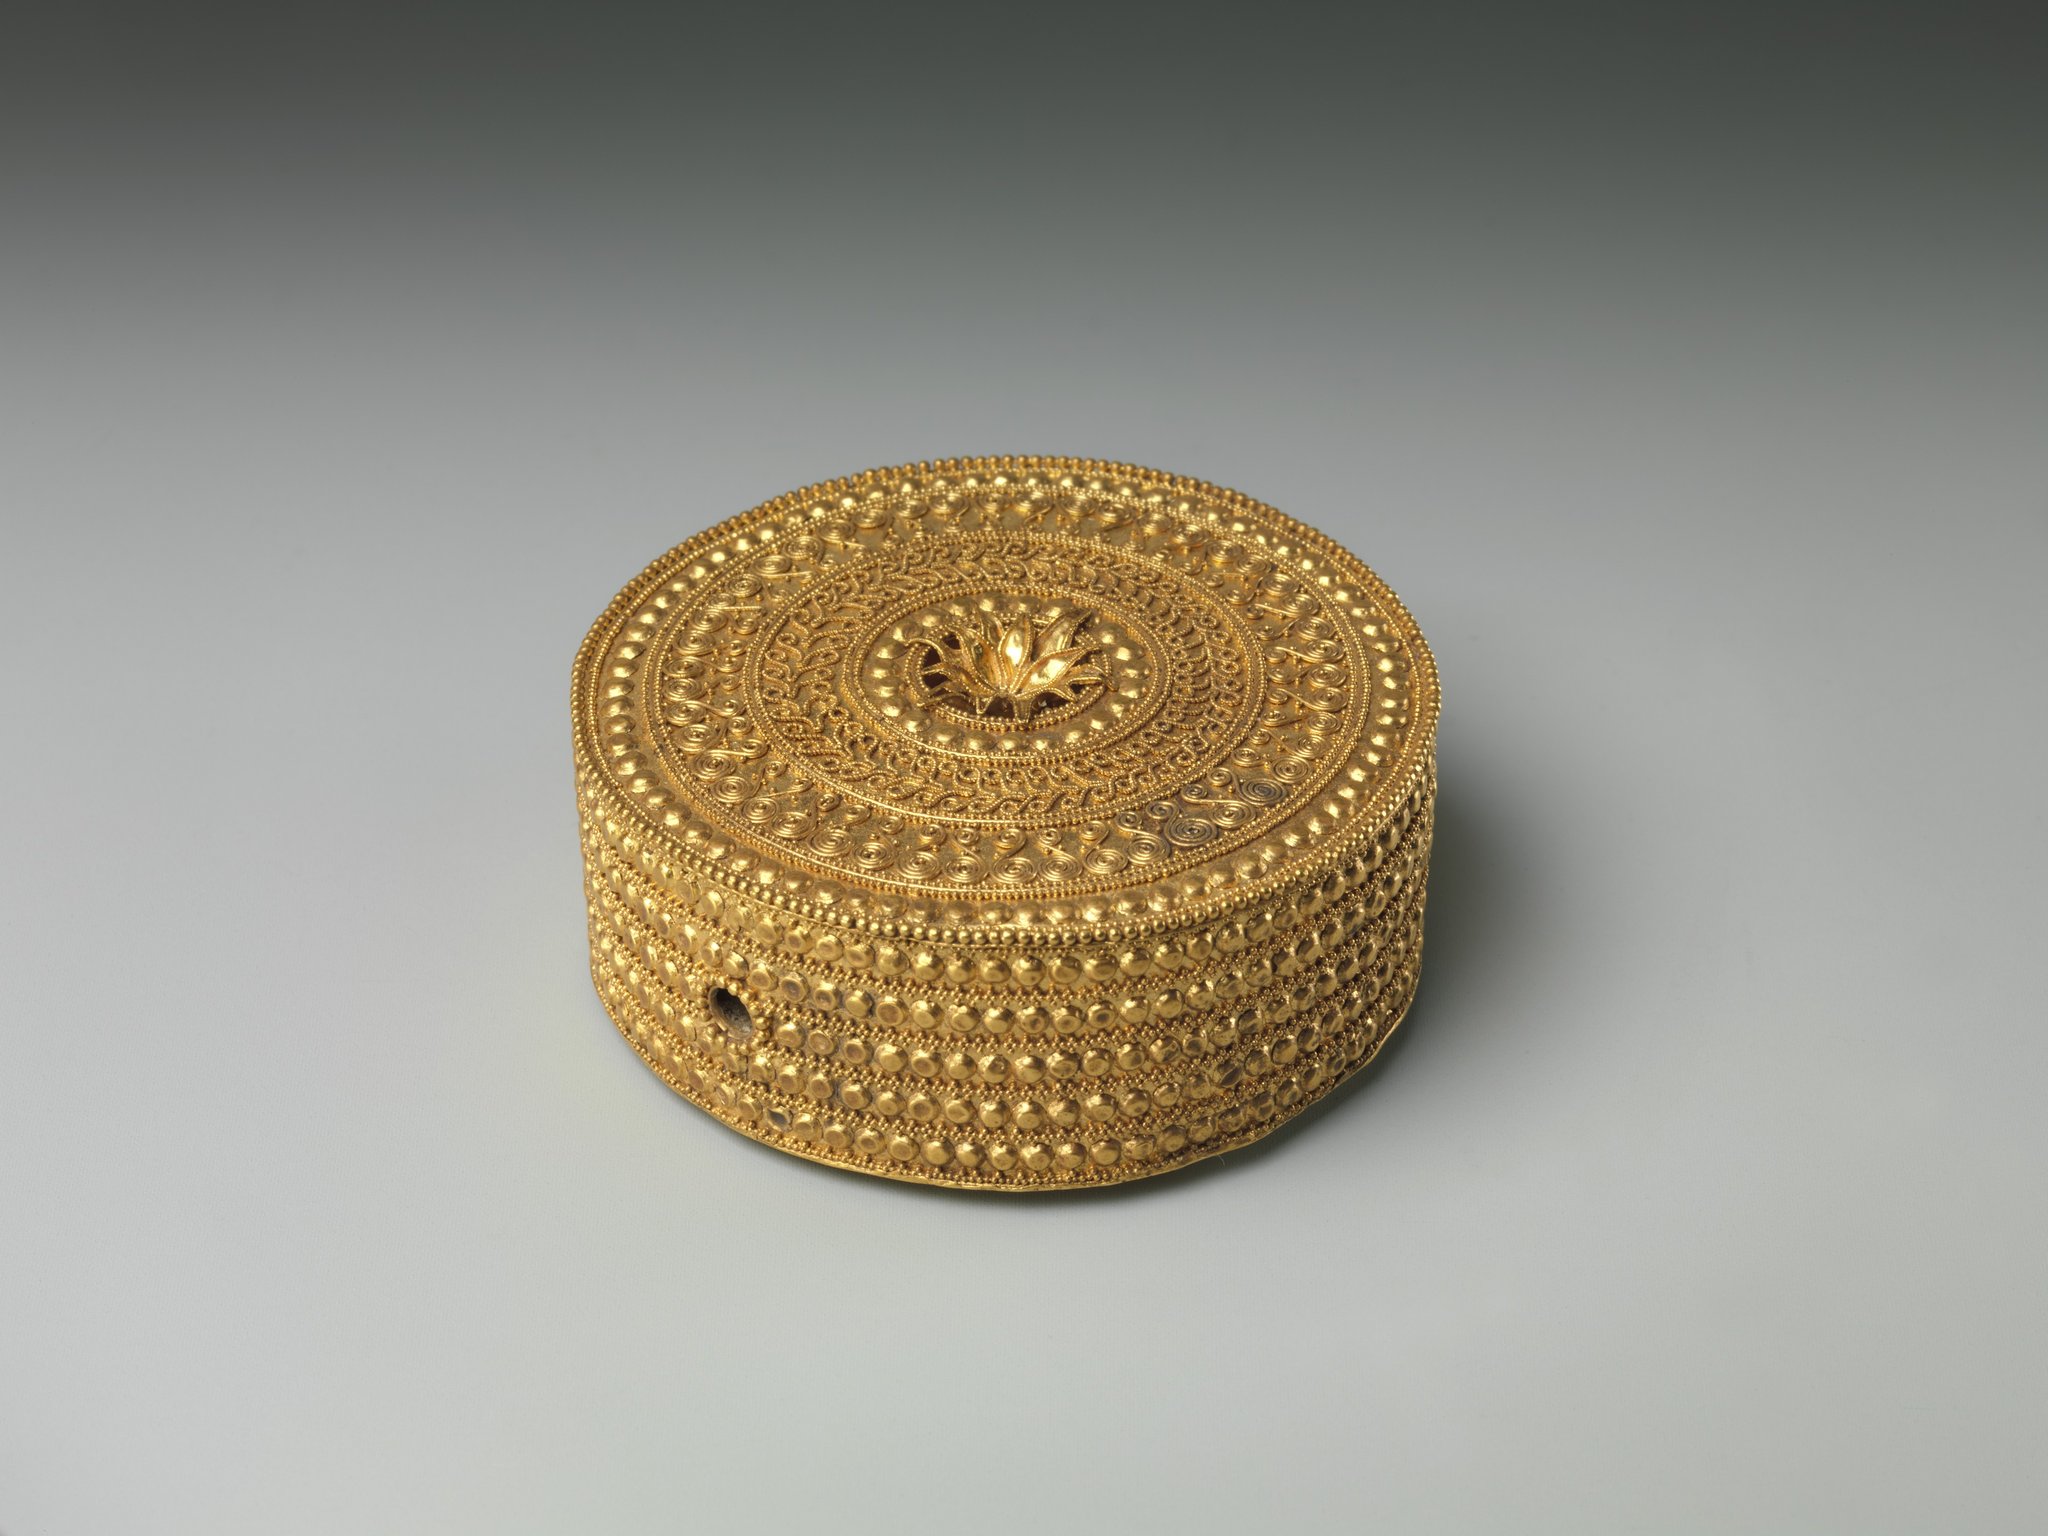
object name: box, ornament, granulation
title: Box-form ornament with granulation and filagree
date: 600-301 BCE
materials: gold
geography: egypt